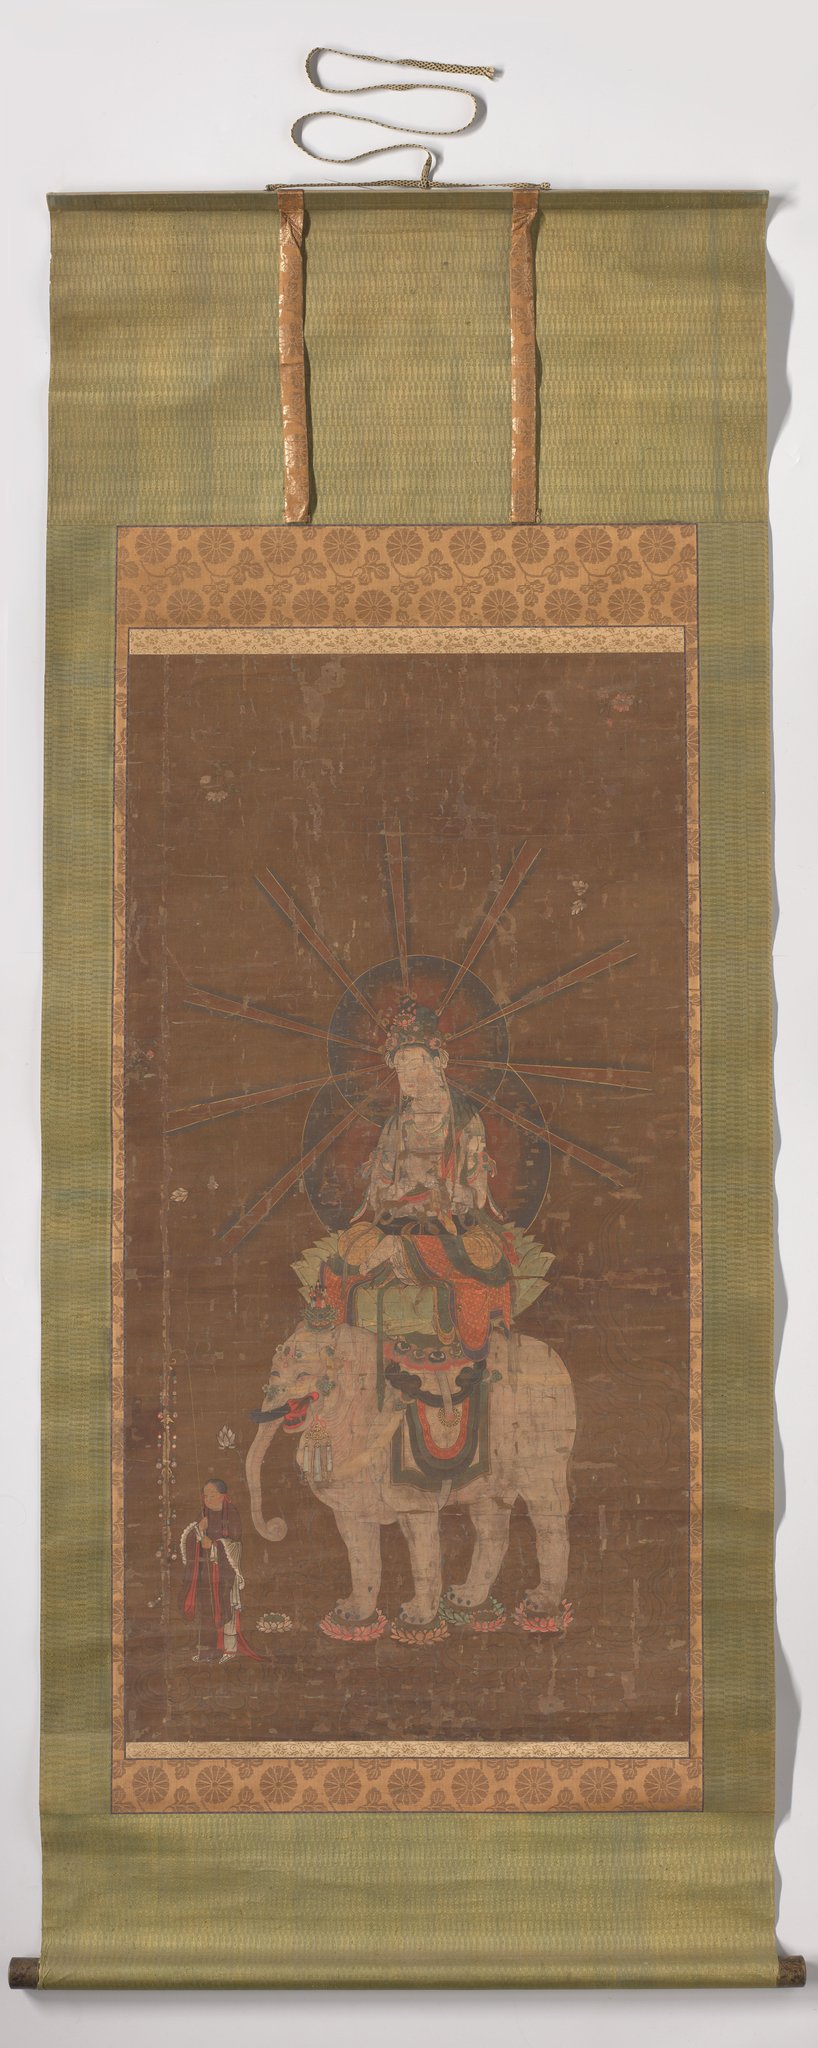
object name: hanging scroll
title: Rolschildering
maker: Anonymous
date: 1800-1900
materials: paint, silk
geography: japan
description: De bodhisattva Samantabhadra (Jap.Fugen), gezeten op zijn olifant. In houten doos.